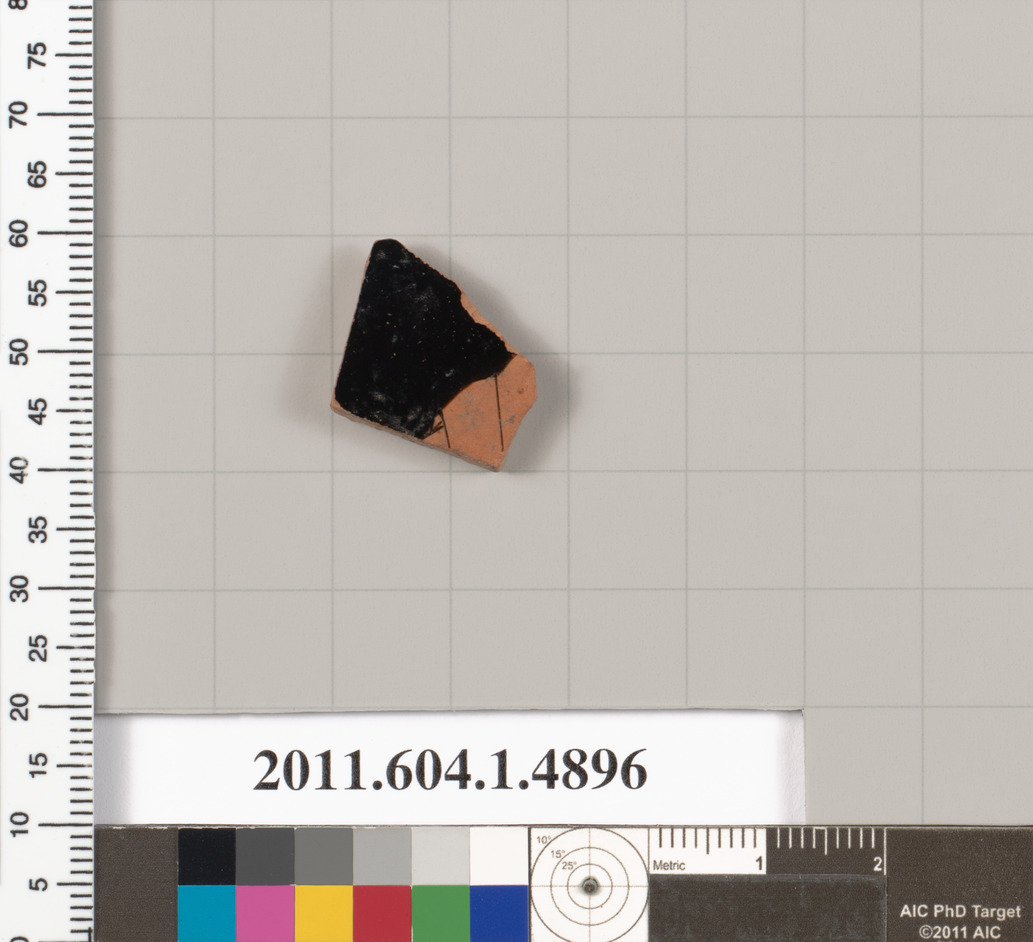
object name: kylix fragment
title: Terracotta fragment of a kylix (drinking cup)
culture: greek, attic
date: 490-470 BCE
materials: terracotta